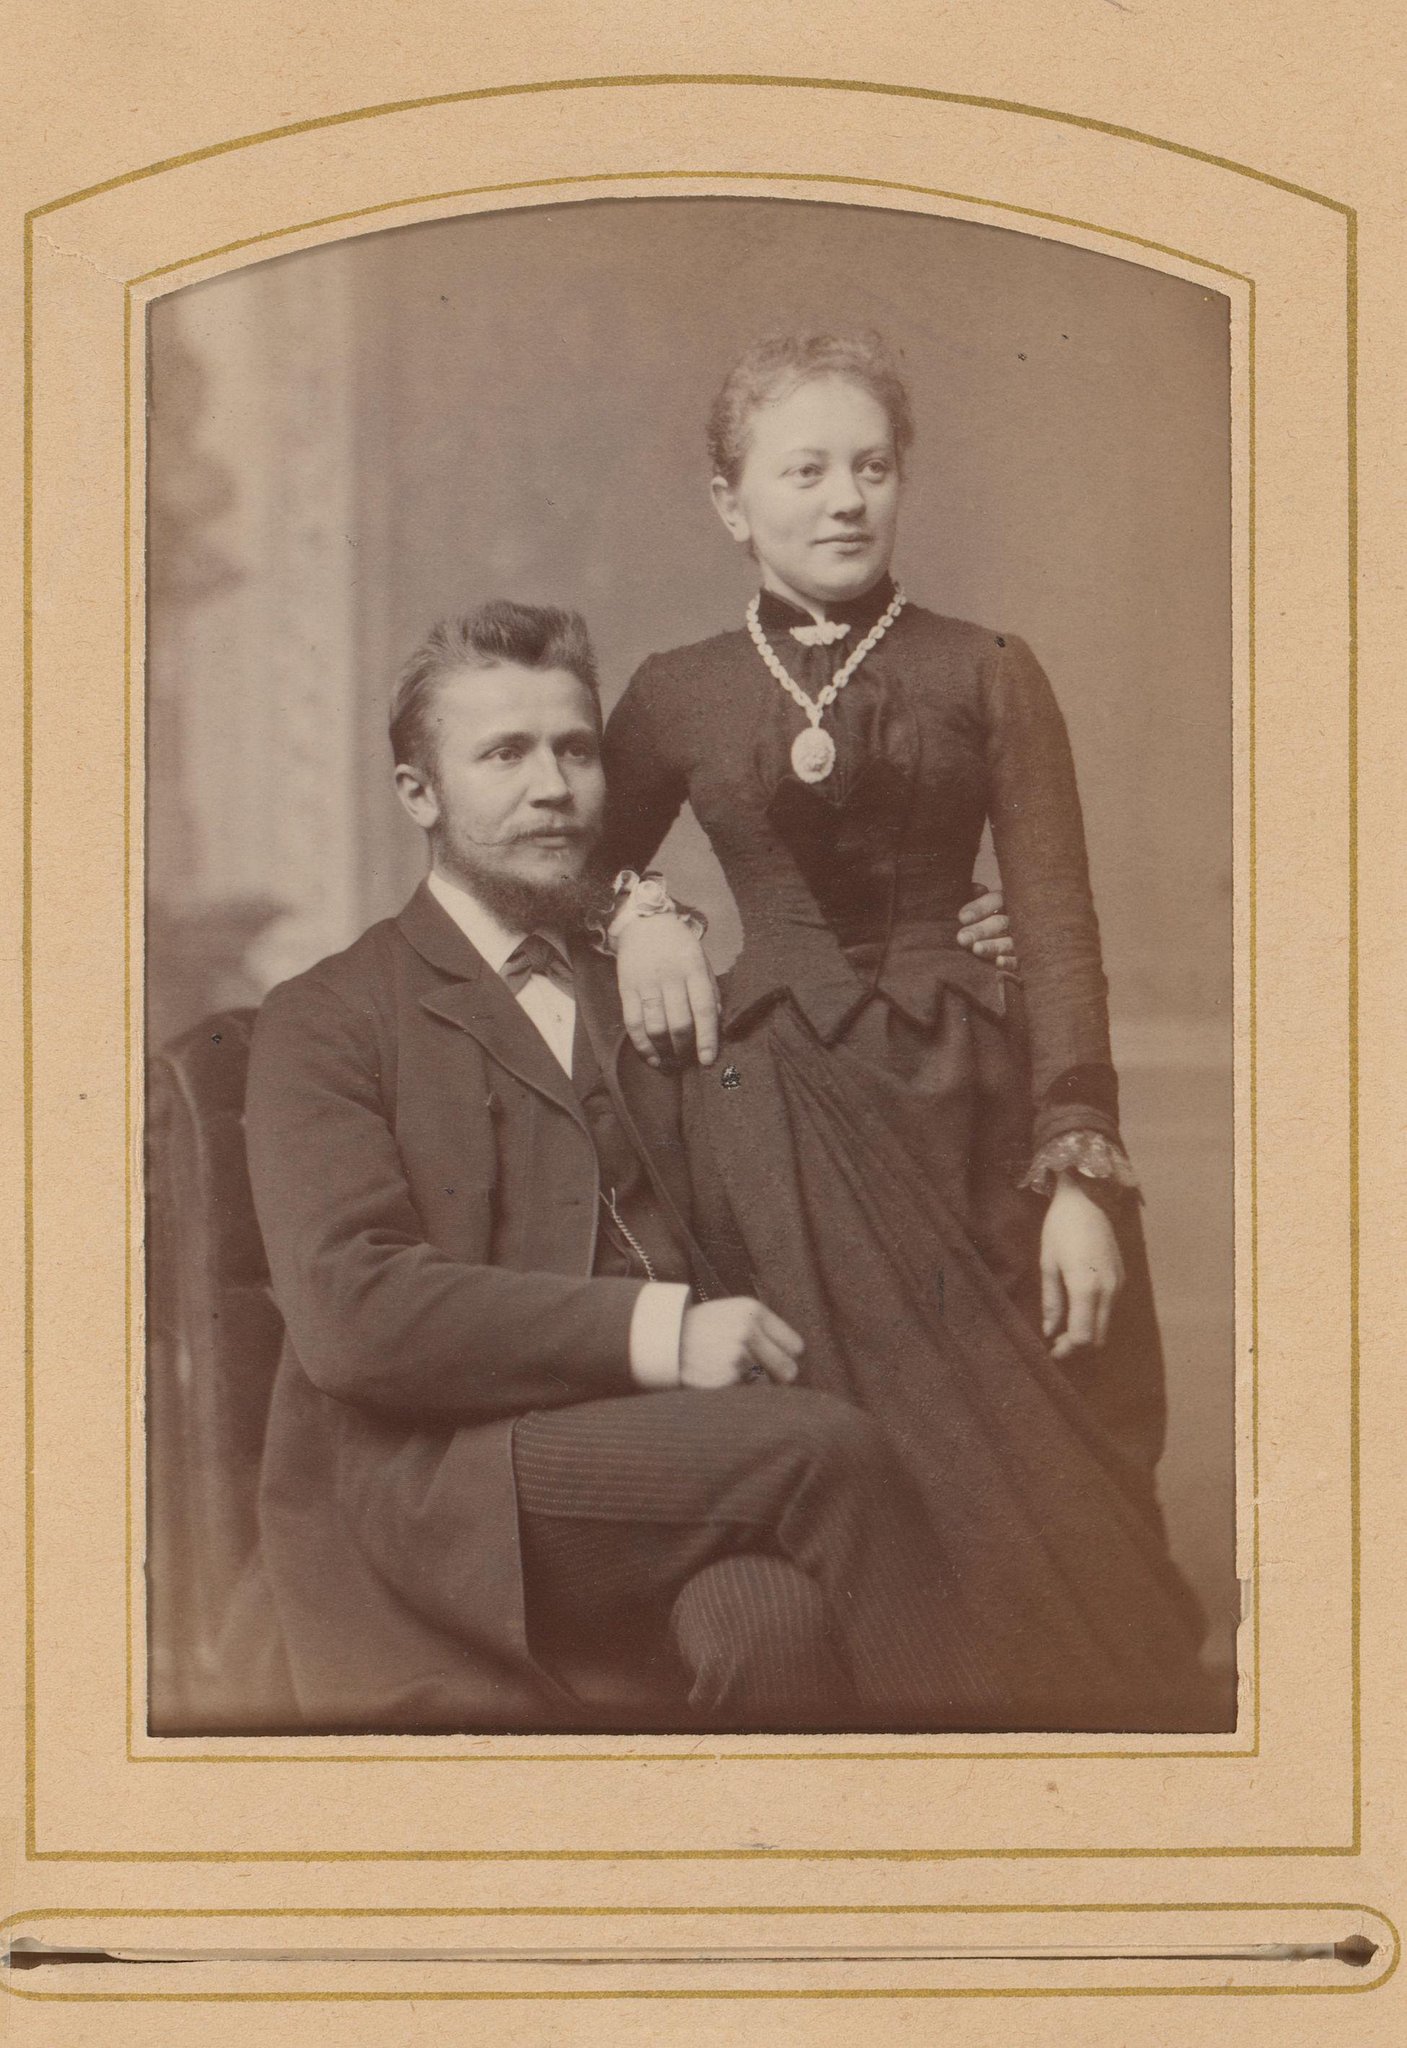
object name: photograph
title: Portret van een zittende man en een staande vrouw met medaillon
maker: franz koebcke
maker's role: fotograaf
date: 1860-1900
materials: cardboard, photographic support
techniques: albumen print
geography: dresden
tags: sitting figure, historical persons - bb - woman, historical persons, standing figure - aa - female human figure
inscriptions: inscription: ‘FRANZ KOEBCKE/ MALER und HOFPHOTOGRAPH/ S. Hoheit des Herzogs v. Sachsen-Meiningen/ MOLTKE-PLATZ 4/ parterre/ DRESDEN./ Die Platten beliben fü Nachbestellungen aufbewahrt und/ können jederzeit Abzüge sowies Vergrösserungen davon/ geliefert werden.’